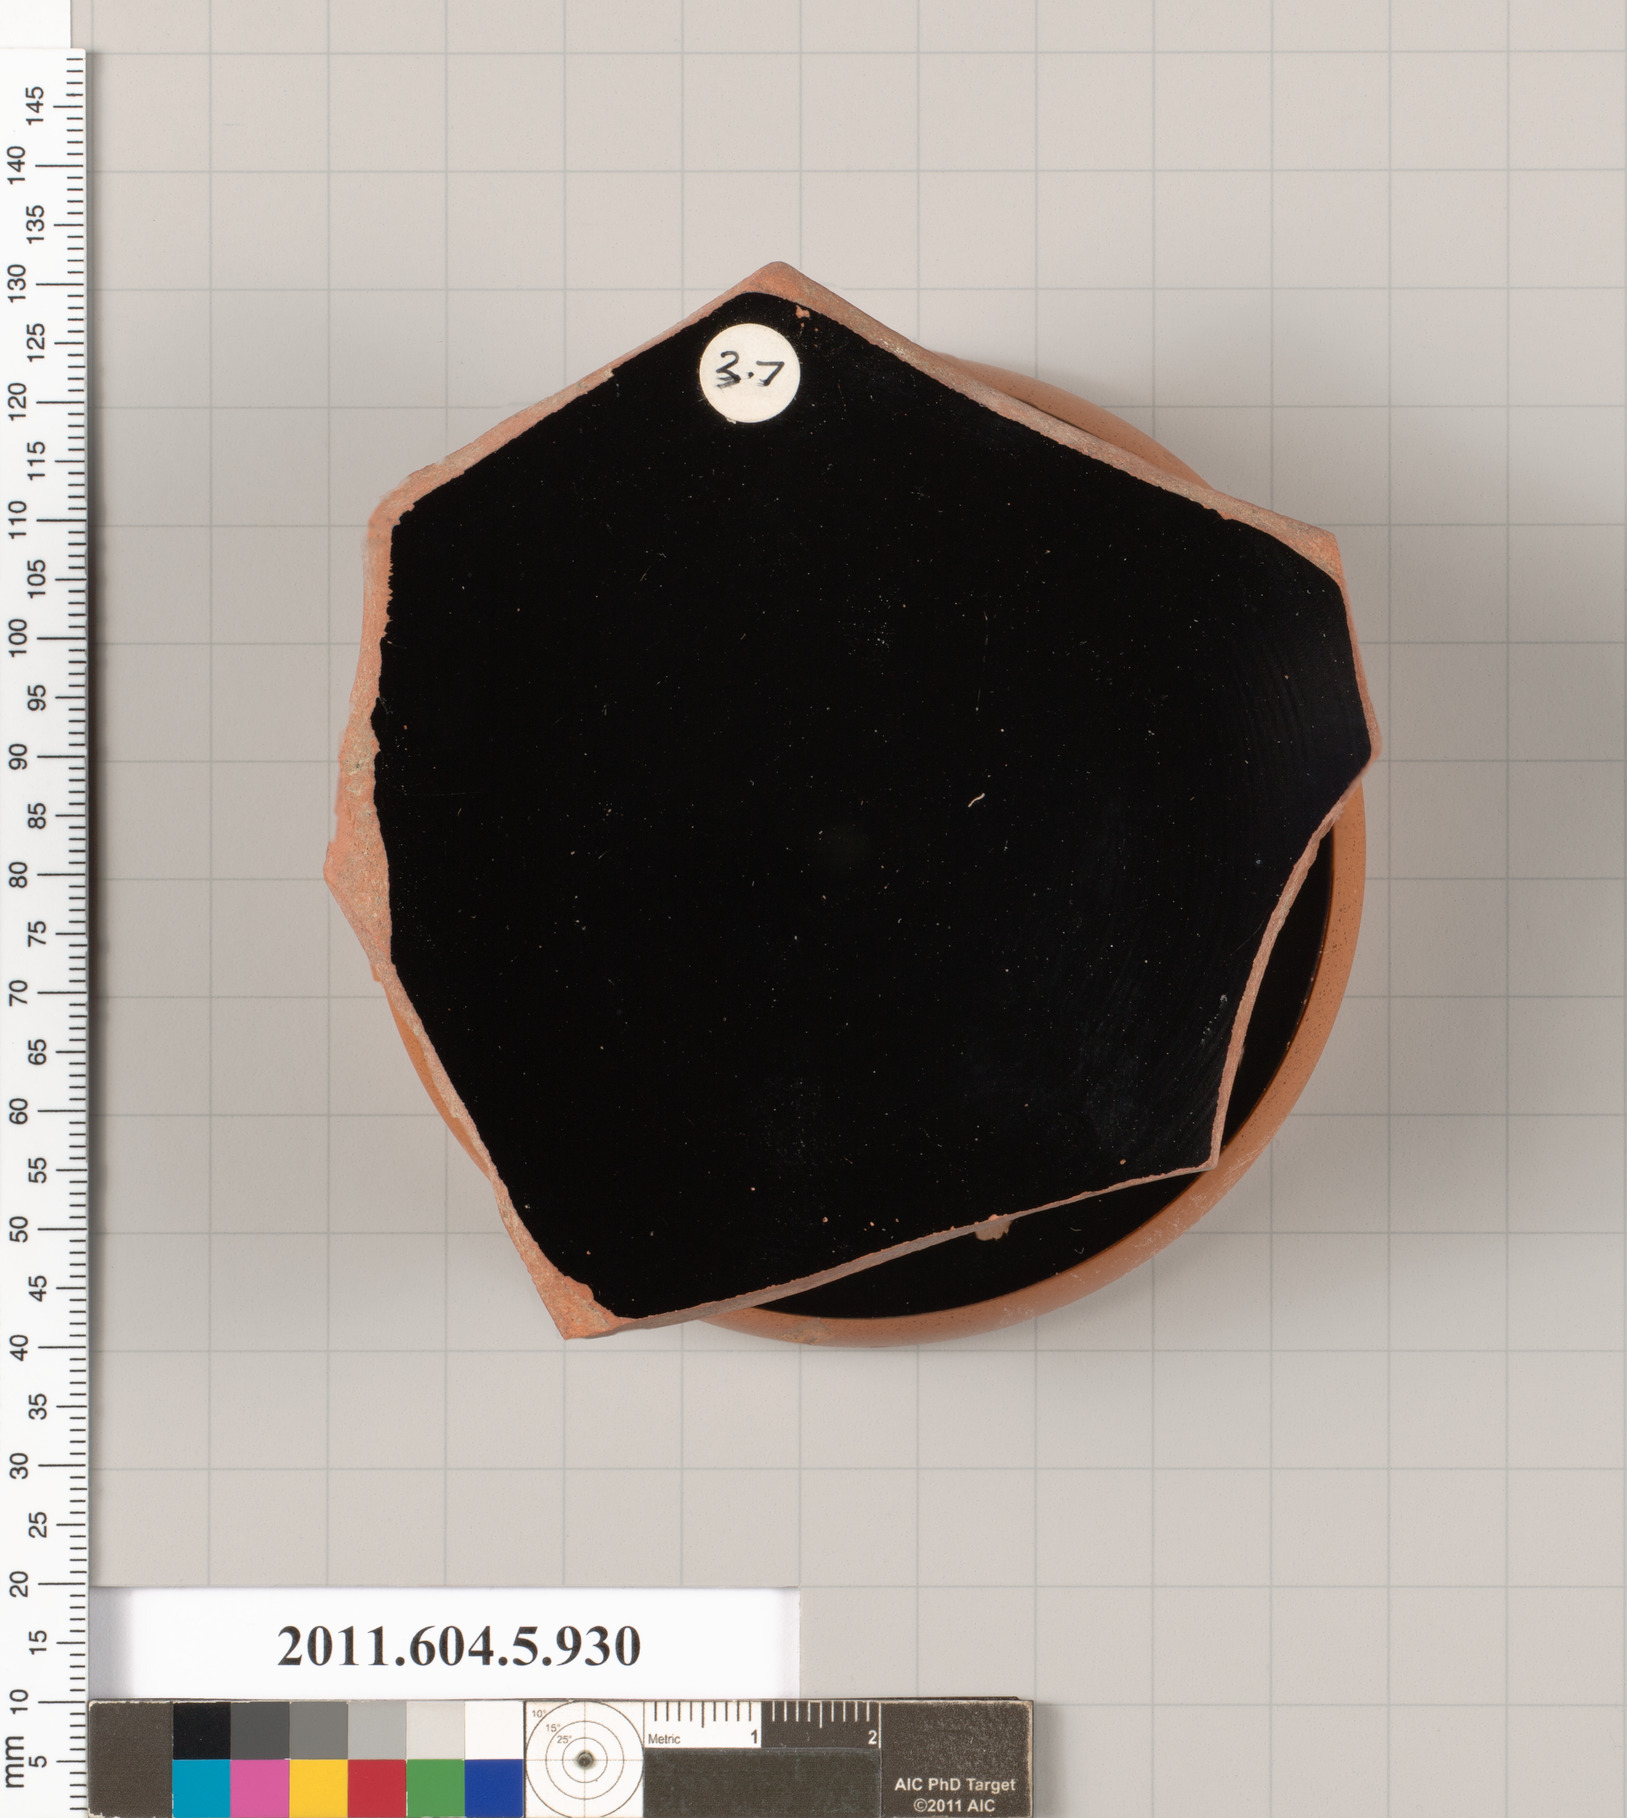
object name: kylix fragment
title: Terracotta fragment of a kylix (drinking cup)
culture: greek, attic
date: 600-401 BCE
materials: terracotta